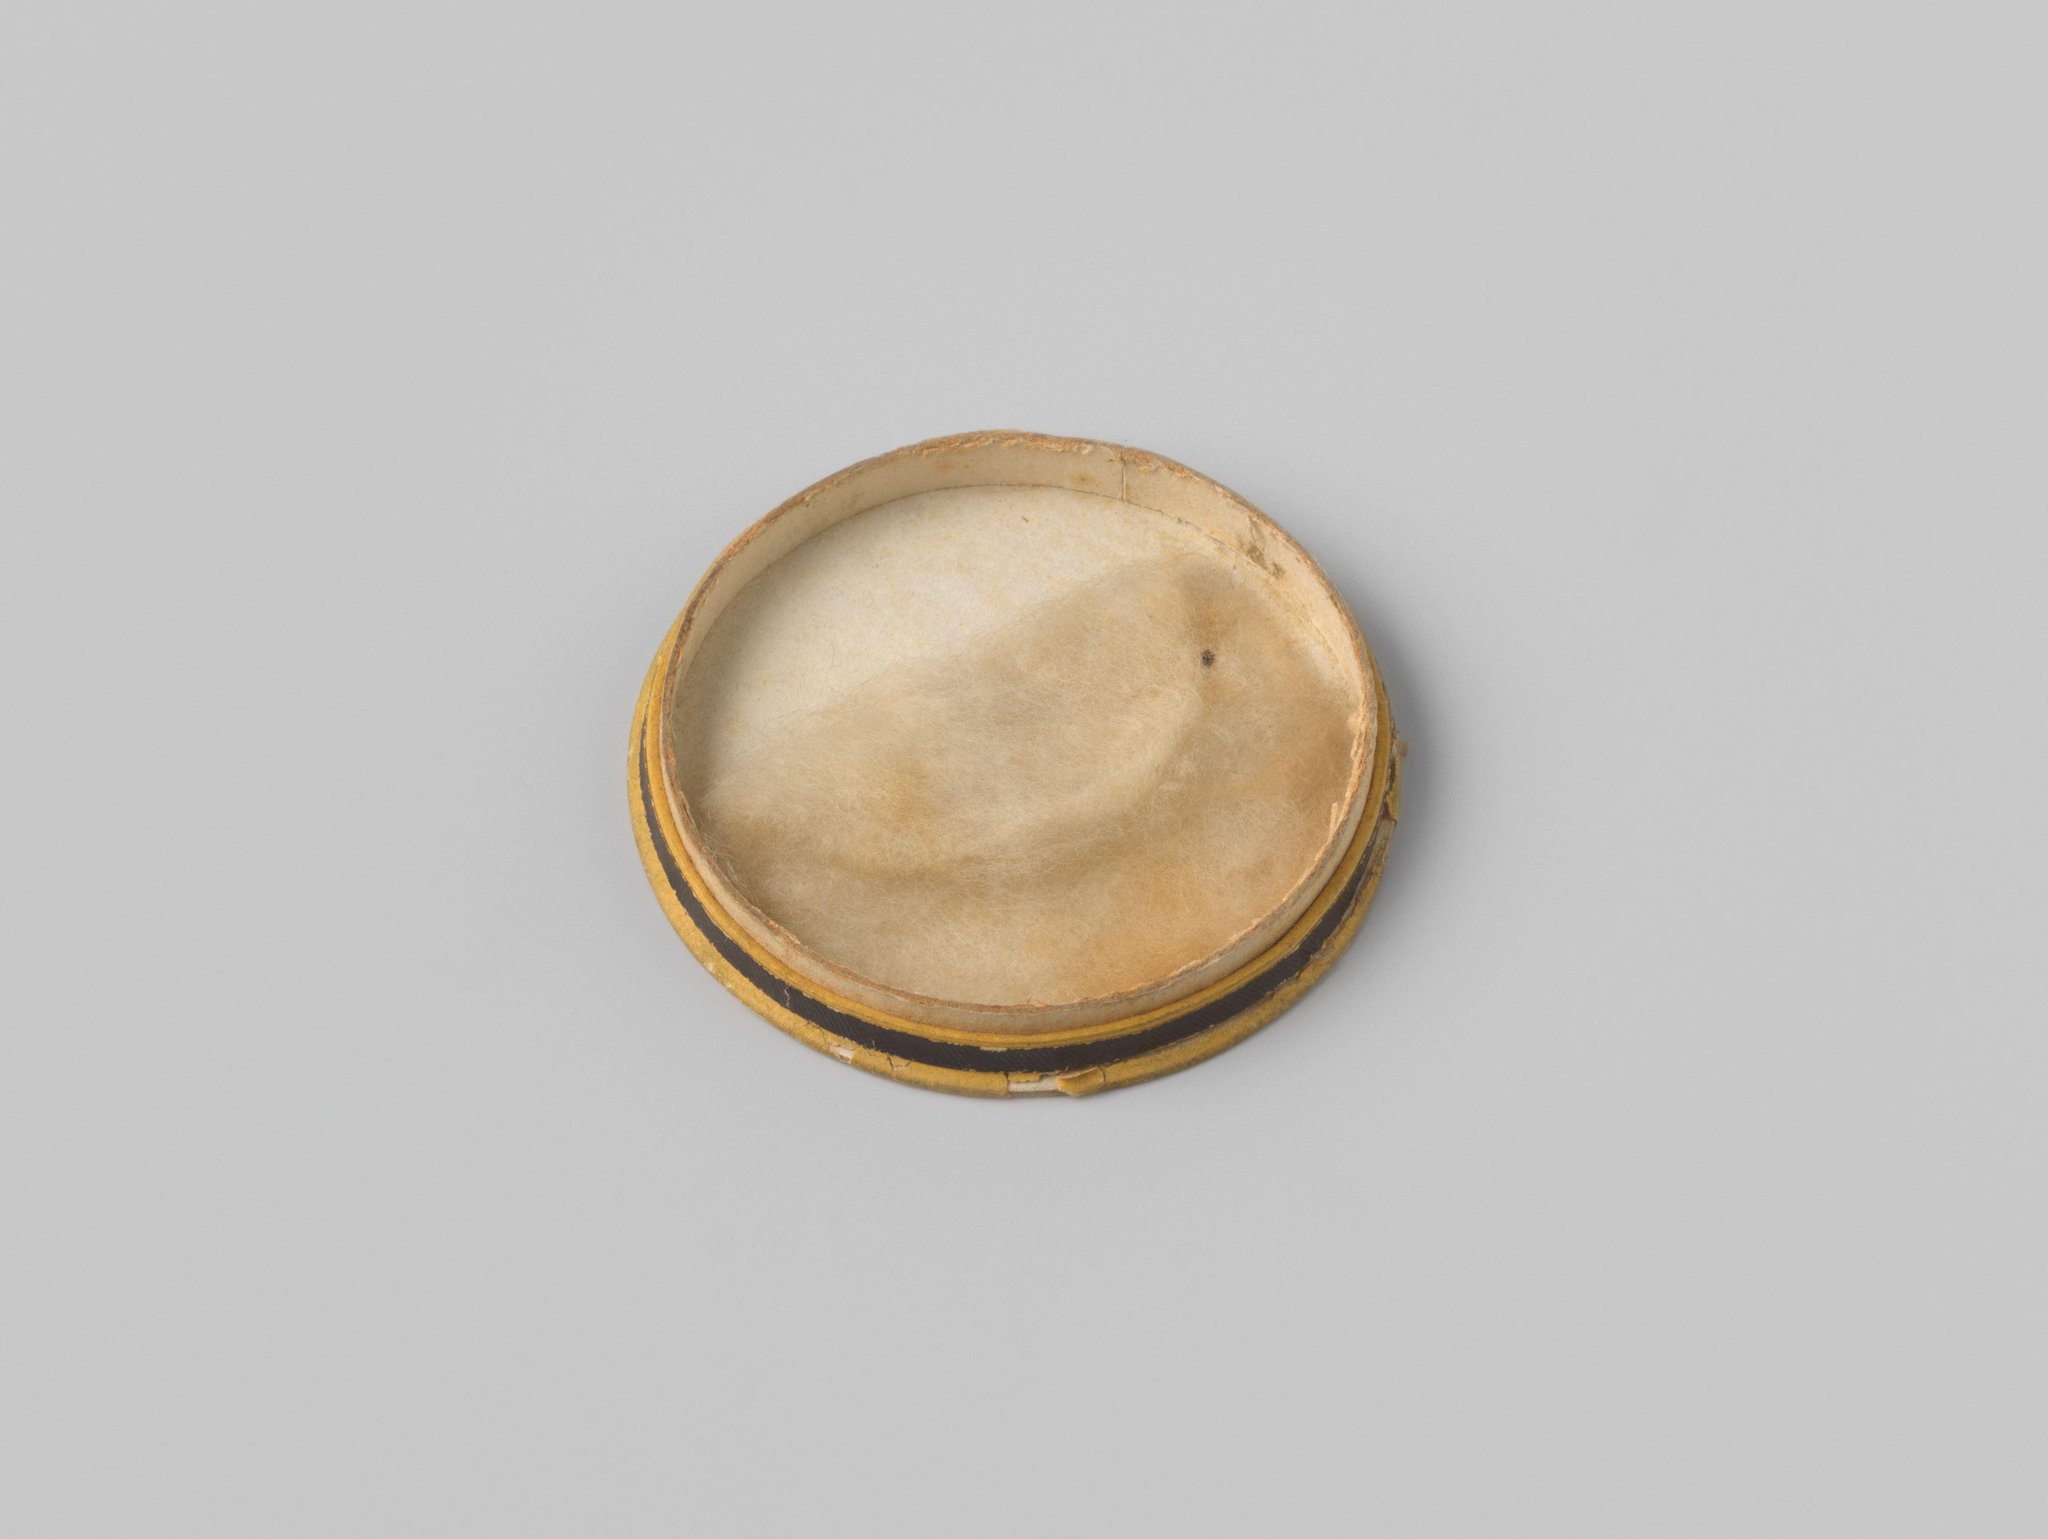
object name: box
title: Doos horend bij een bronzen penning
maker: edouard louis geerts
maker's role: medailleur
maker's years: 1846-1889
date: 1874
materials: cardboard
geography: the hague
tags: brussels, willem iii (koning der nederlanden), netherlands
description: Rond kartonnen doosje. De binnenkant is gewatteerd. Deksel ontbreekt.